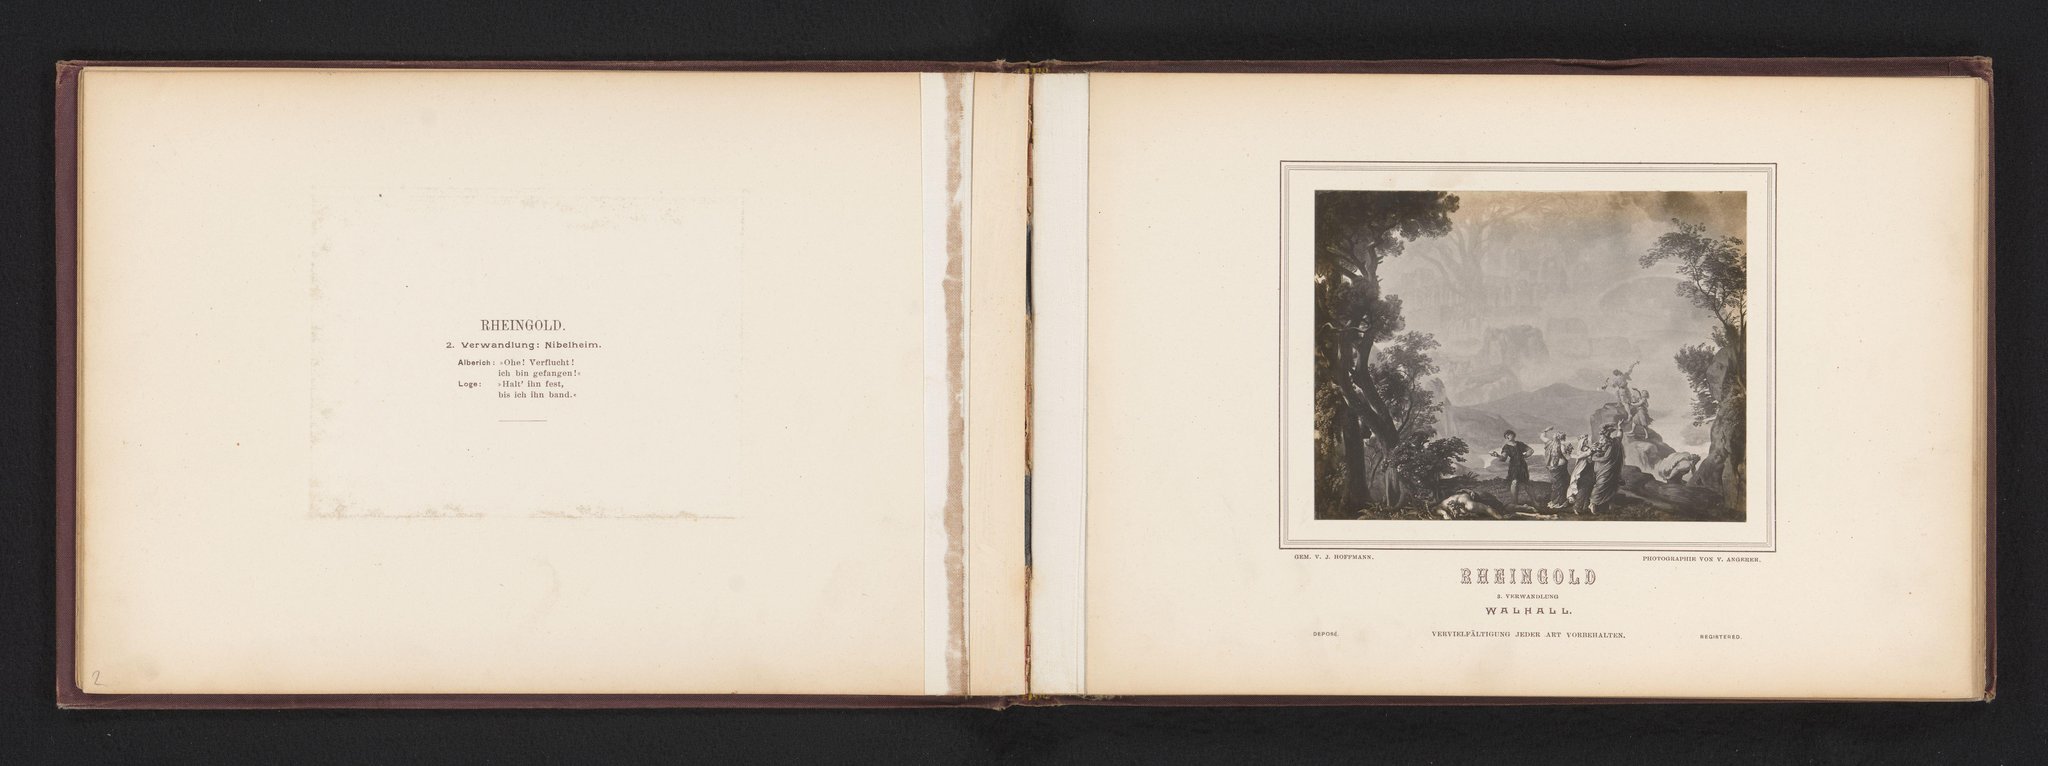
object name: page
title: Rheingold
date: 1866-1876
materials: photographic support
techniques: albumen print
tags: representations ~ gods, demi-gods, heroes etc. (germanic and scandinavian religions), 'nibelungenlied'